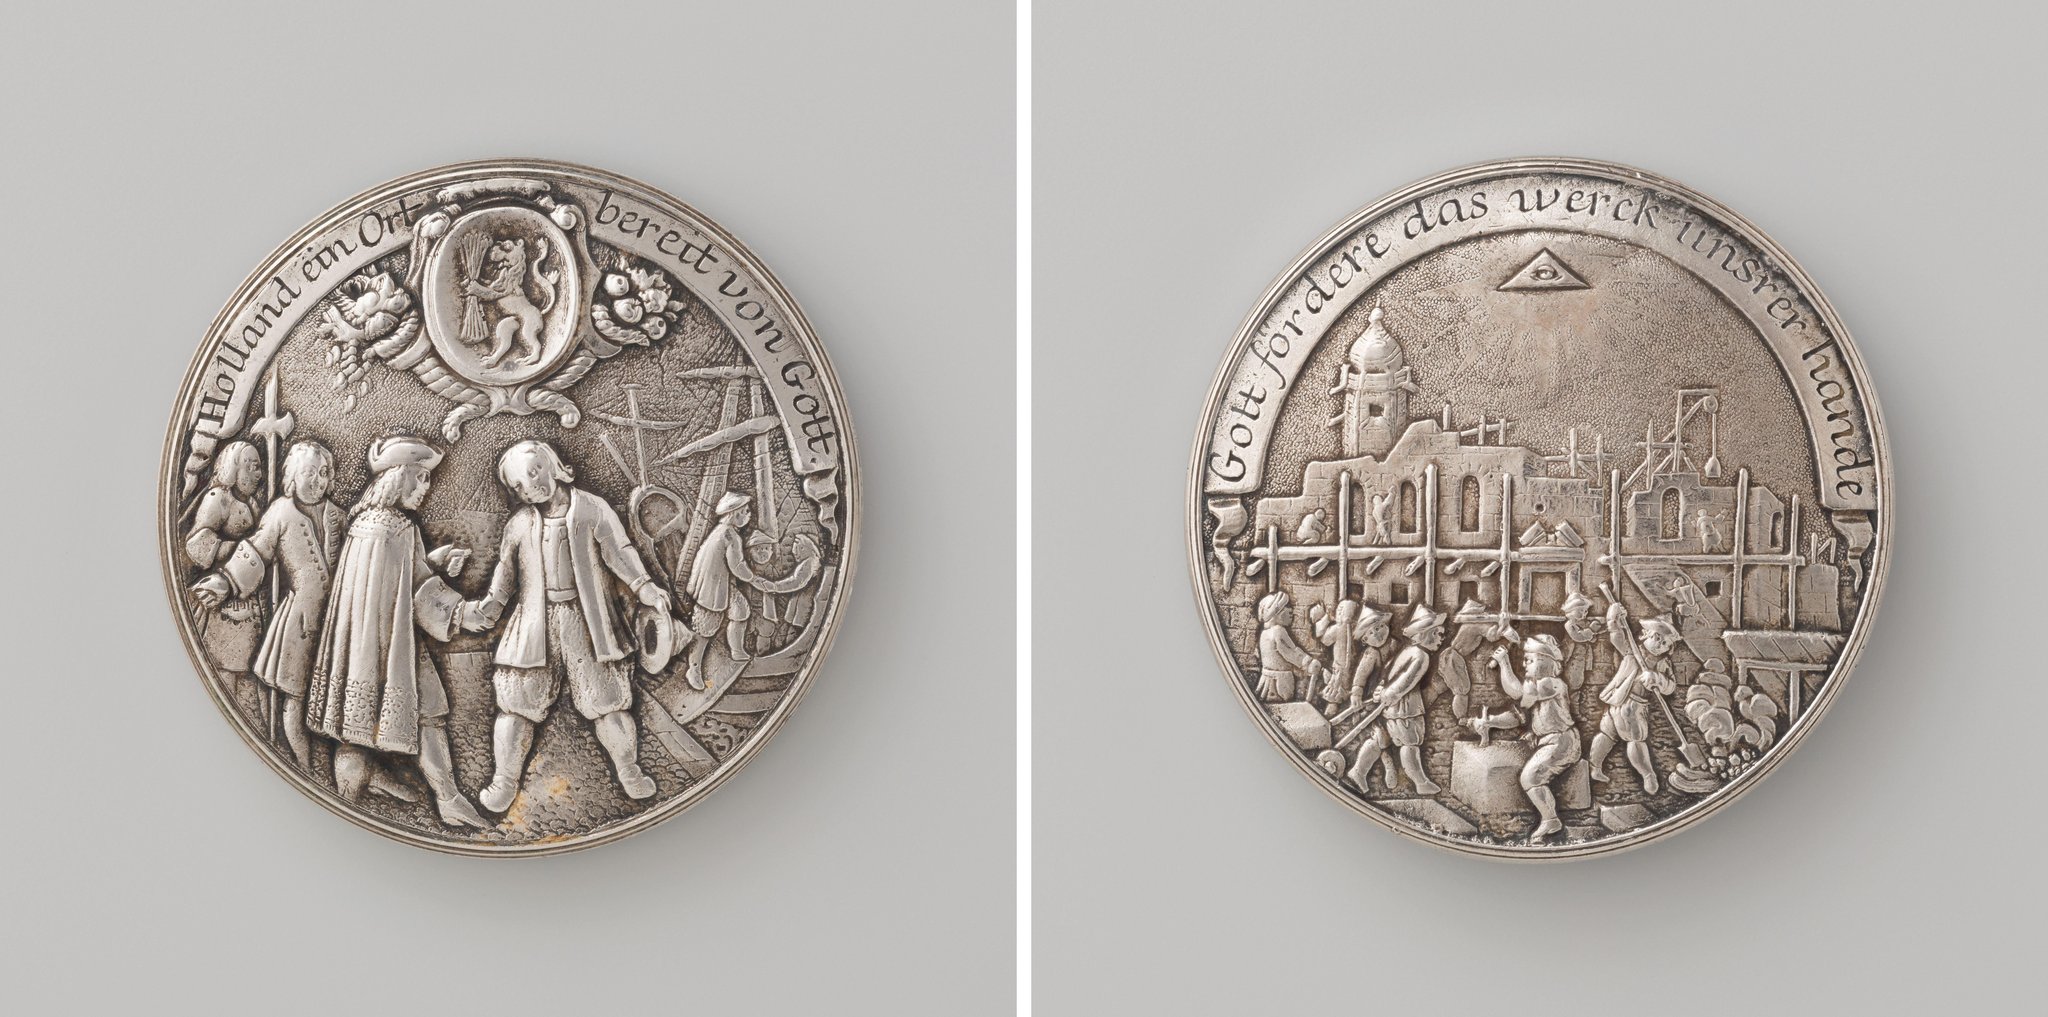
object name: history medal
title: Opname der Salzburger emigranten in Pruisen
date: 1732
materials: paper, silver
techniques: striking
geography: augsburg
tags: drievuldigheidskerk, breskens, litouwen, opname der salzburger emigranten in pruisen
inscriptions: circumscription: ‘Gott fördere das Werck unsrer Hande’, circumscription: ‘Holland ein Ort - bereit von Gott’